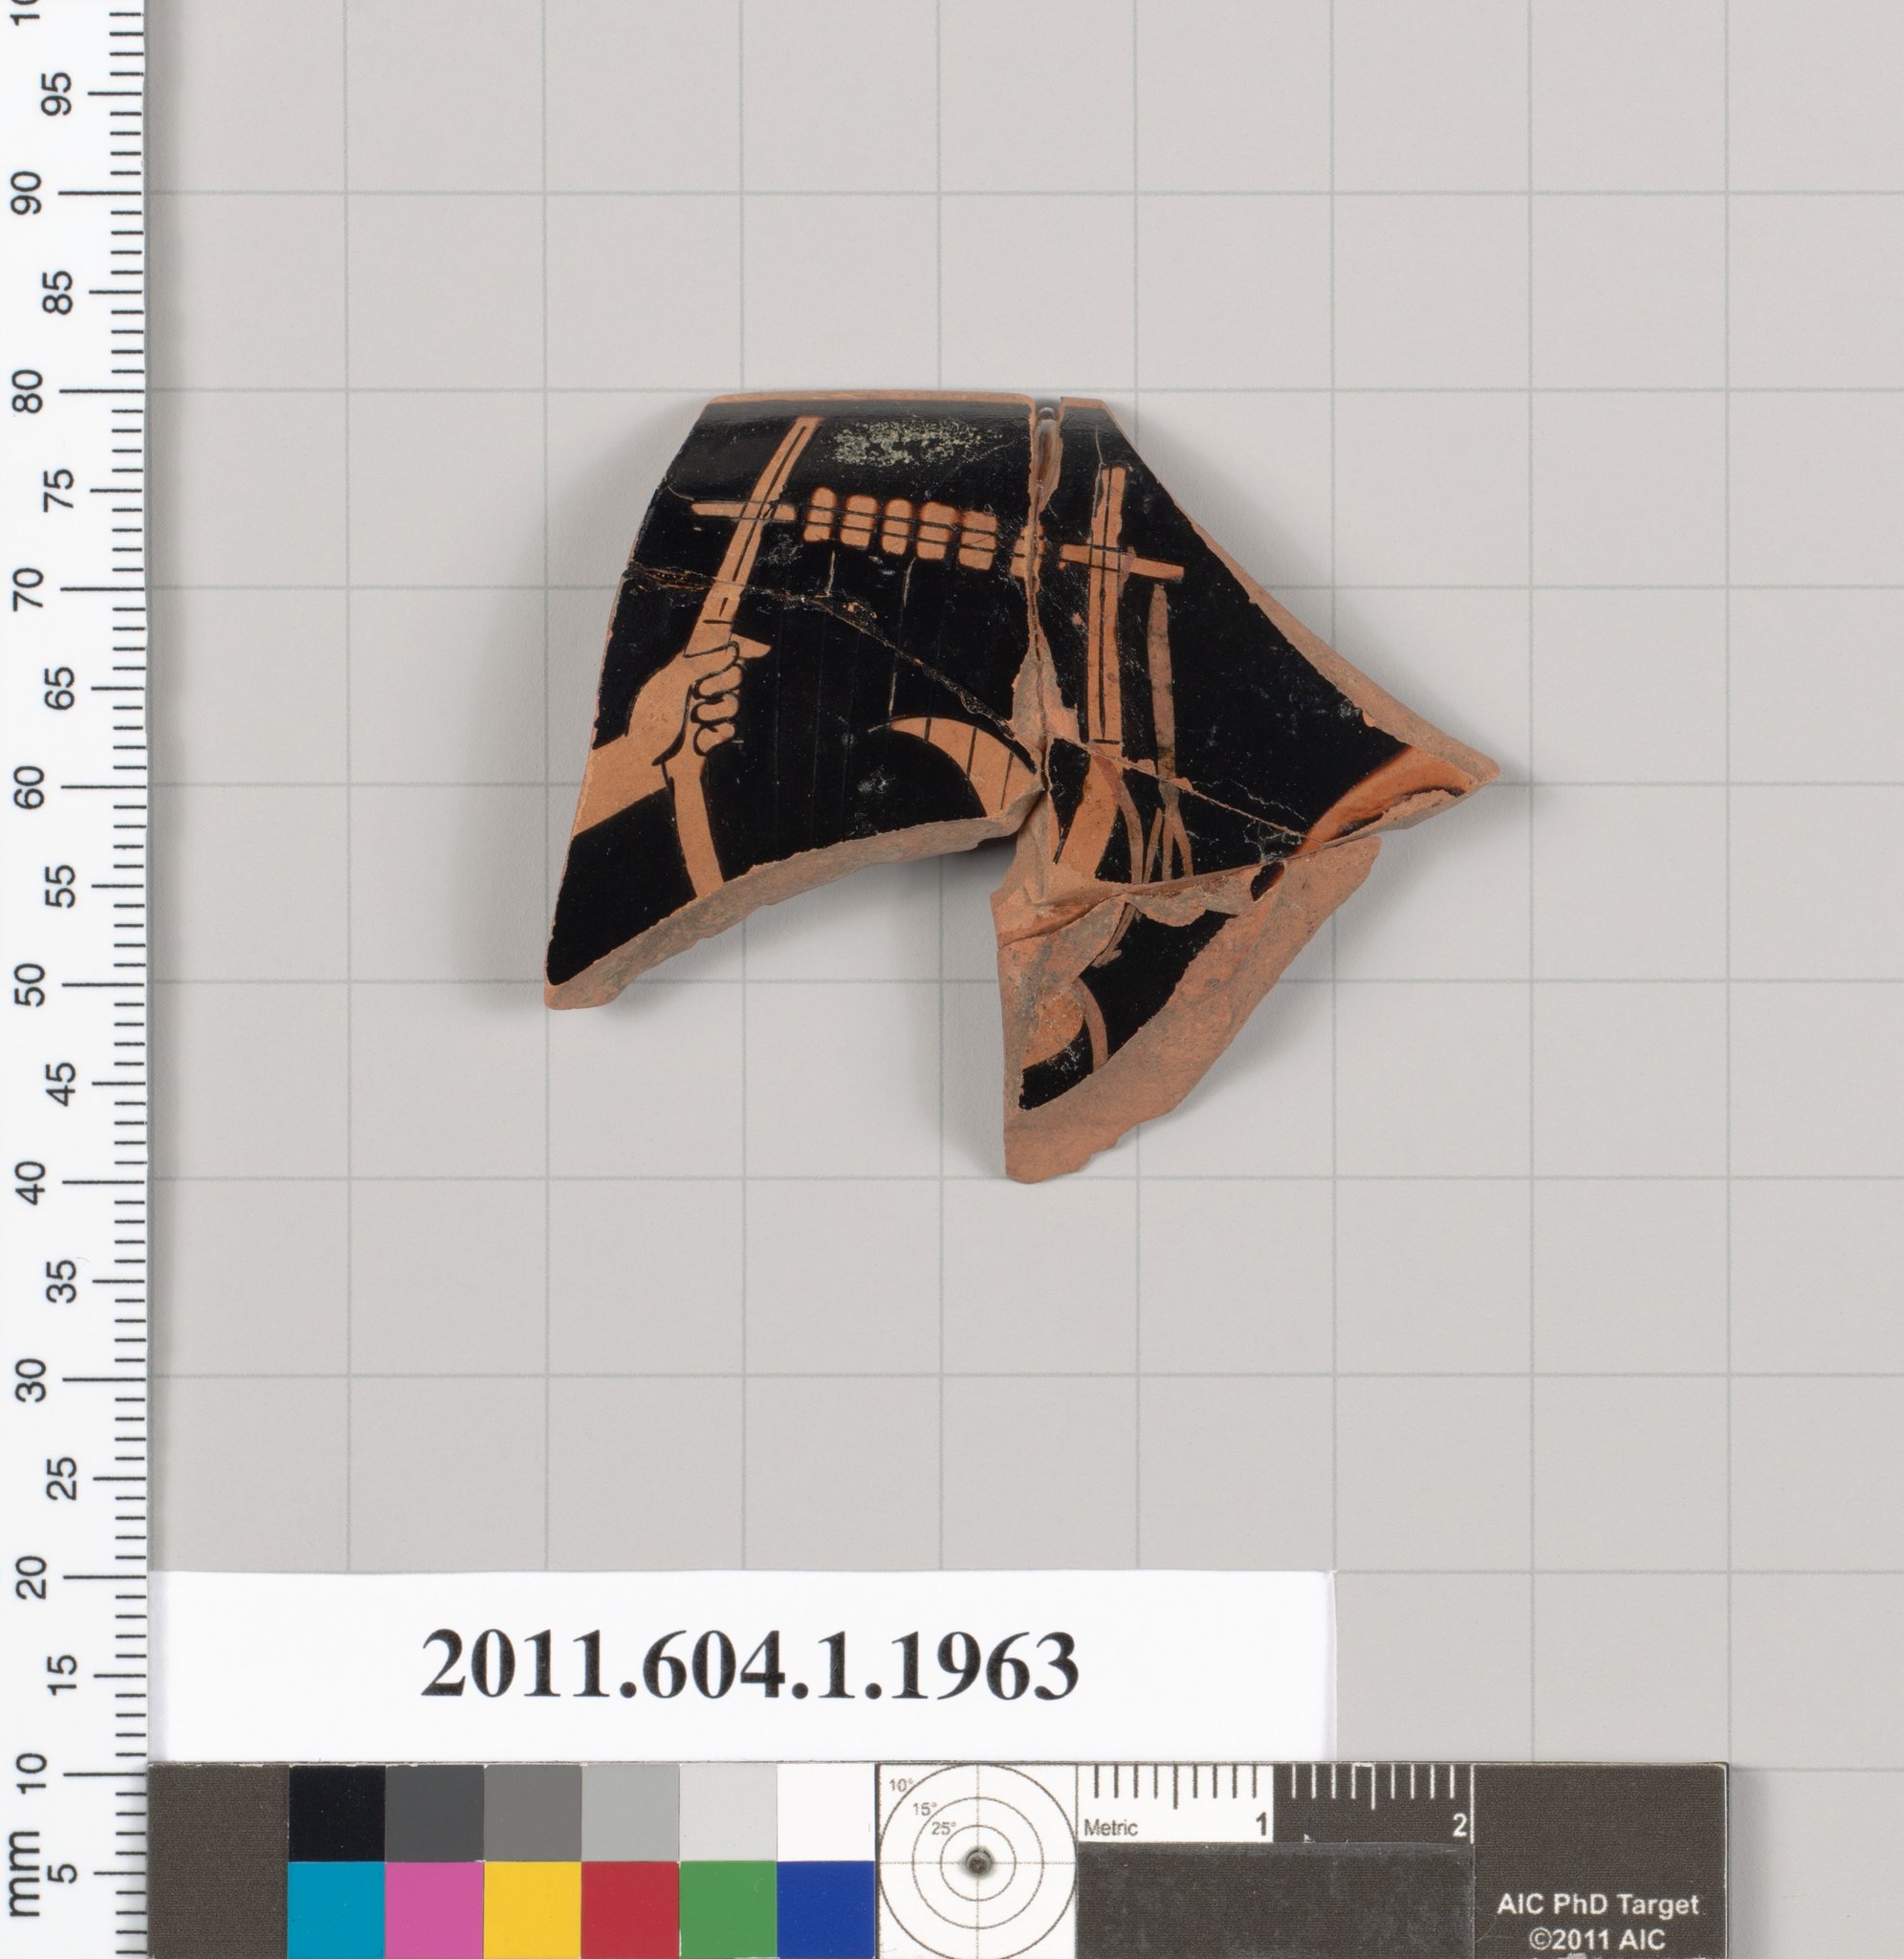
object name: kylix fragment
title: Terracotta rim fragment of a kylix (drinking cup)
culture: greek, attic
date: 490-480 BCE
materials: terracotta